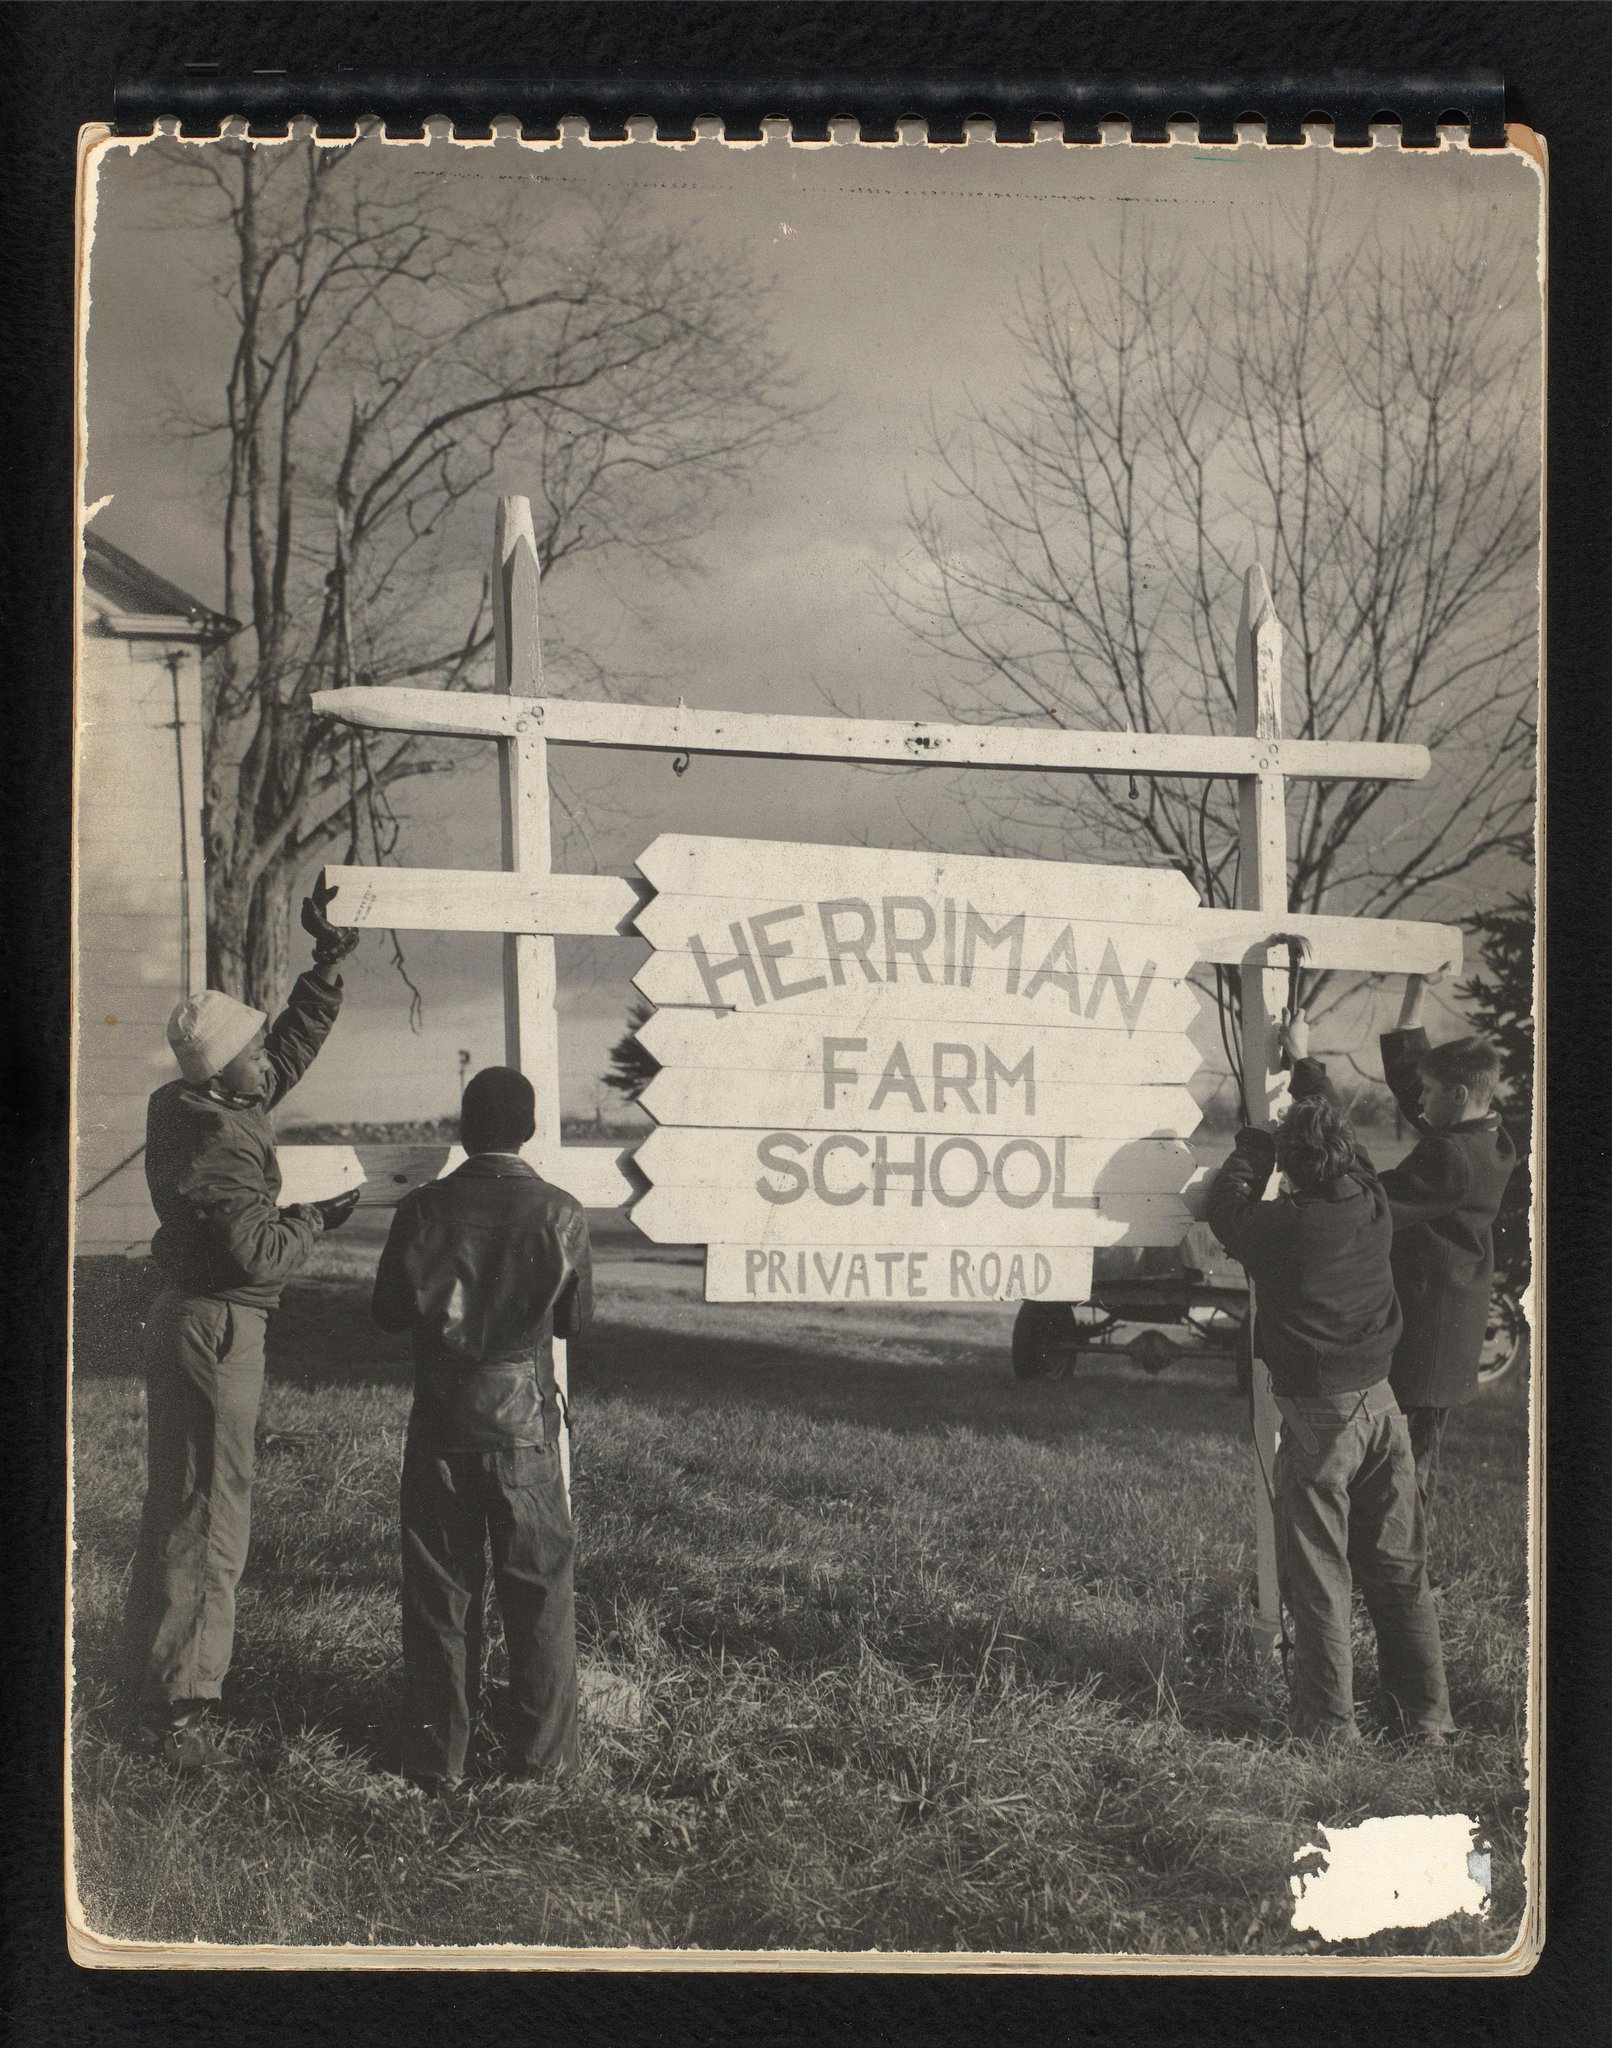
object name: photograph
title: Toegangsbord met vier jongens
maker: Anonymous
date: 1950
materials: paper, photographic support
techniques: gelatin silver print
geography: new york city